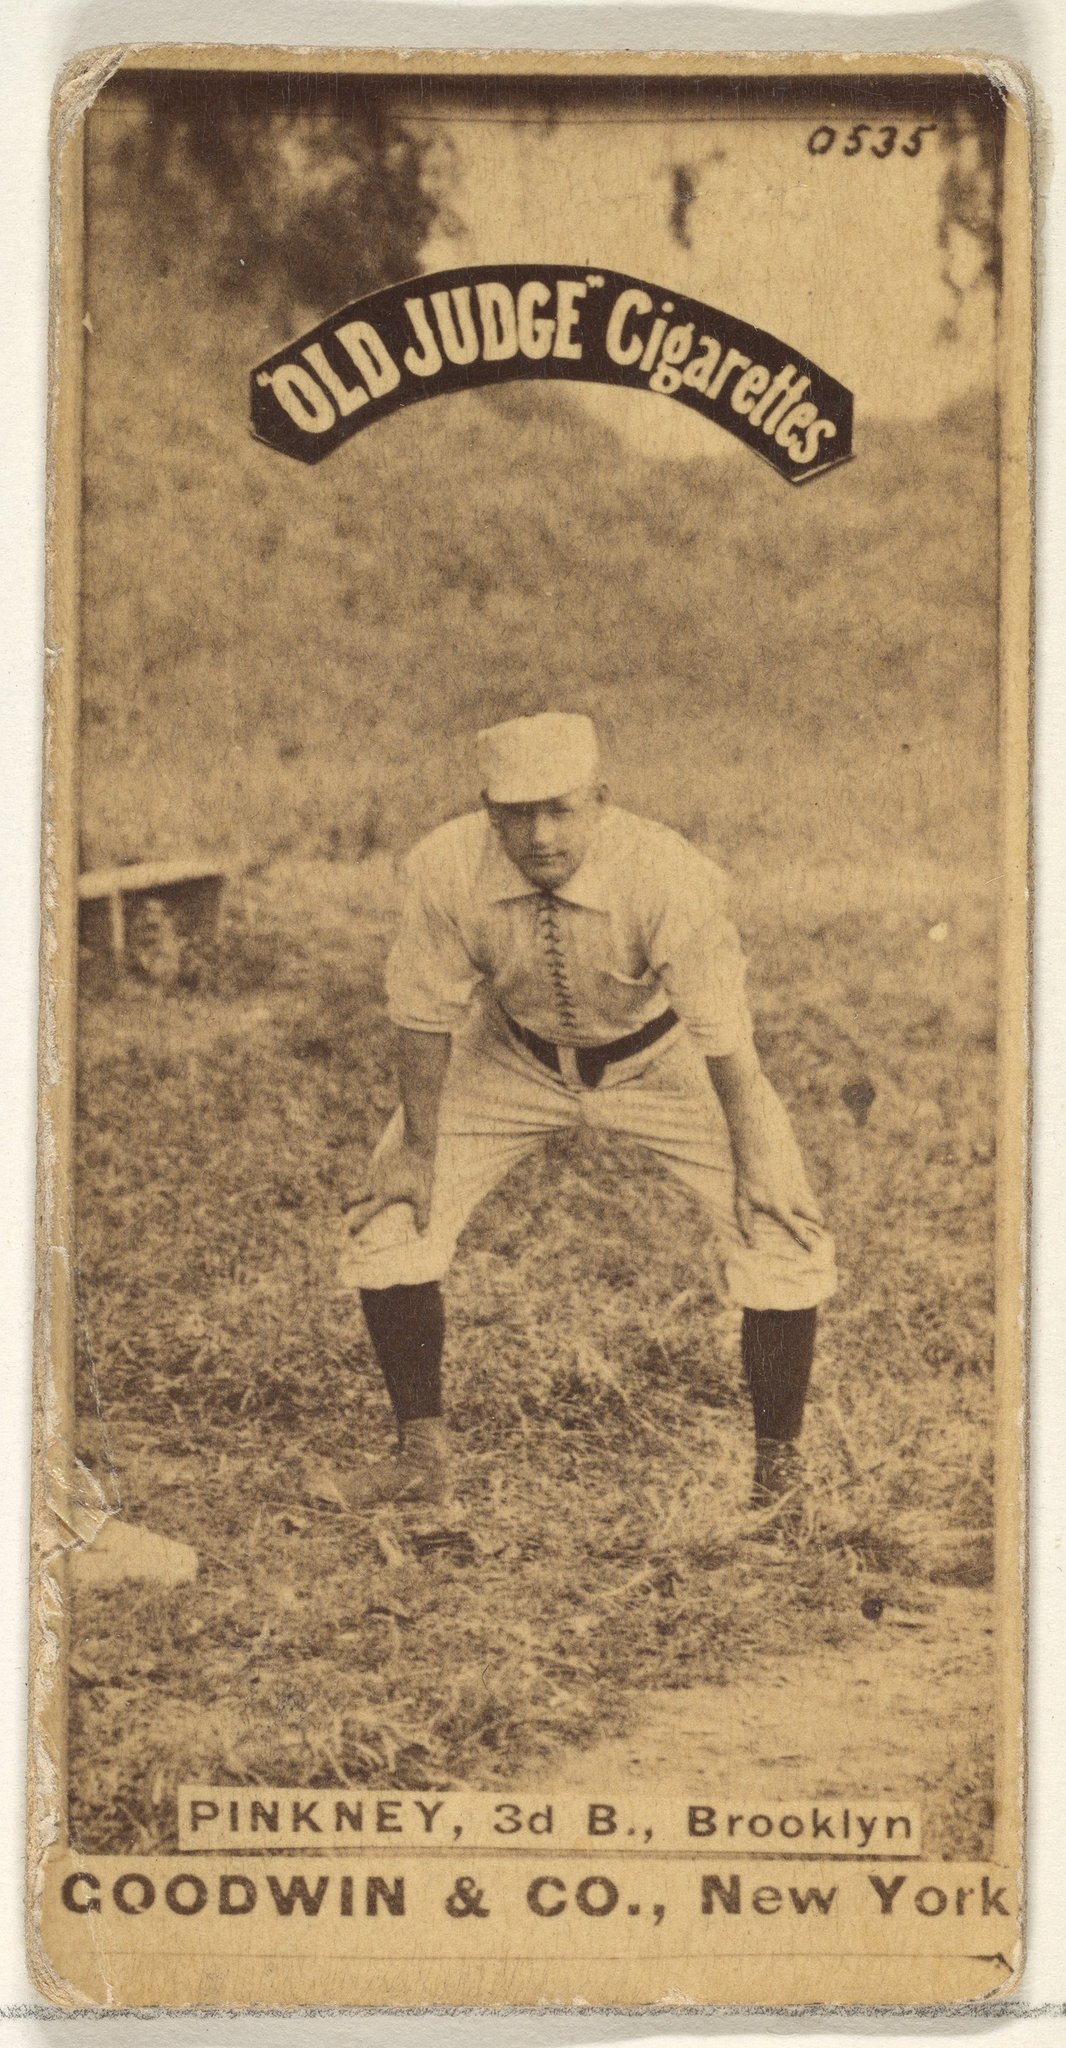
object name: baseball card, photograph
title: Pinkney, 3rd Base, Brooklyn, from the Old Judge series (N172) for Old Judge Cigarettes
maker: goodwin & company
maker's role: publisher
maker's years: 1850-1950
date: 1887-1890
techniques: albumen silver print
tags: men,portraits,baseball,athletes